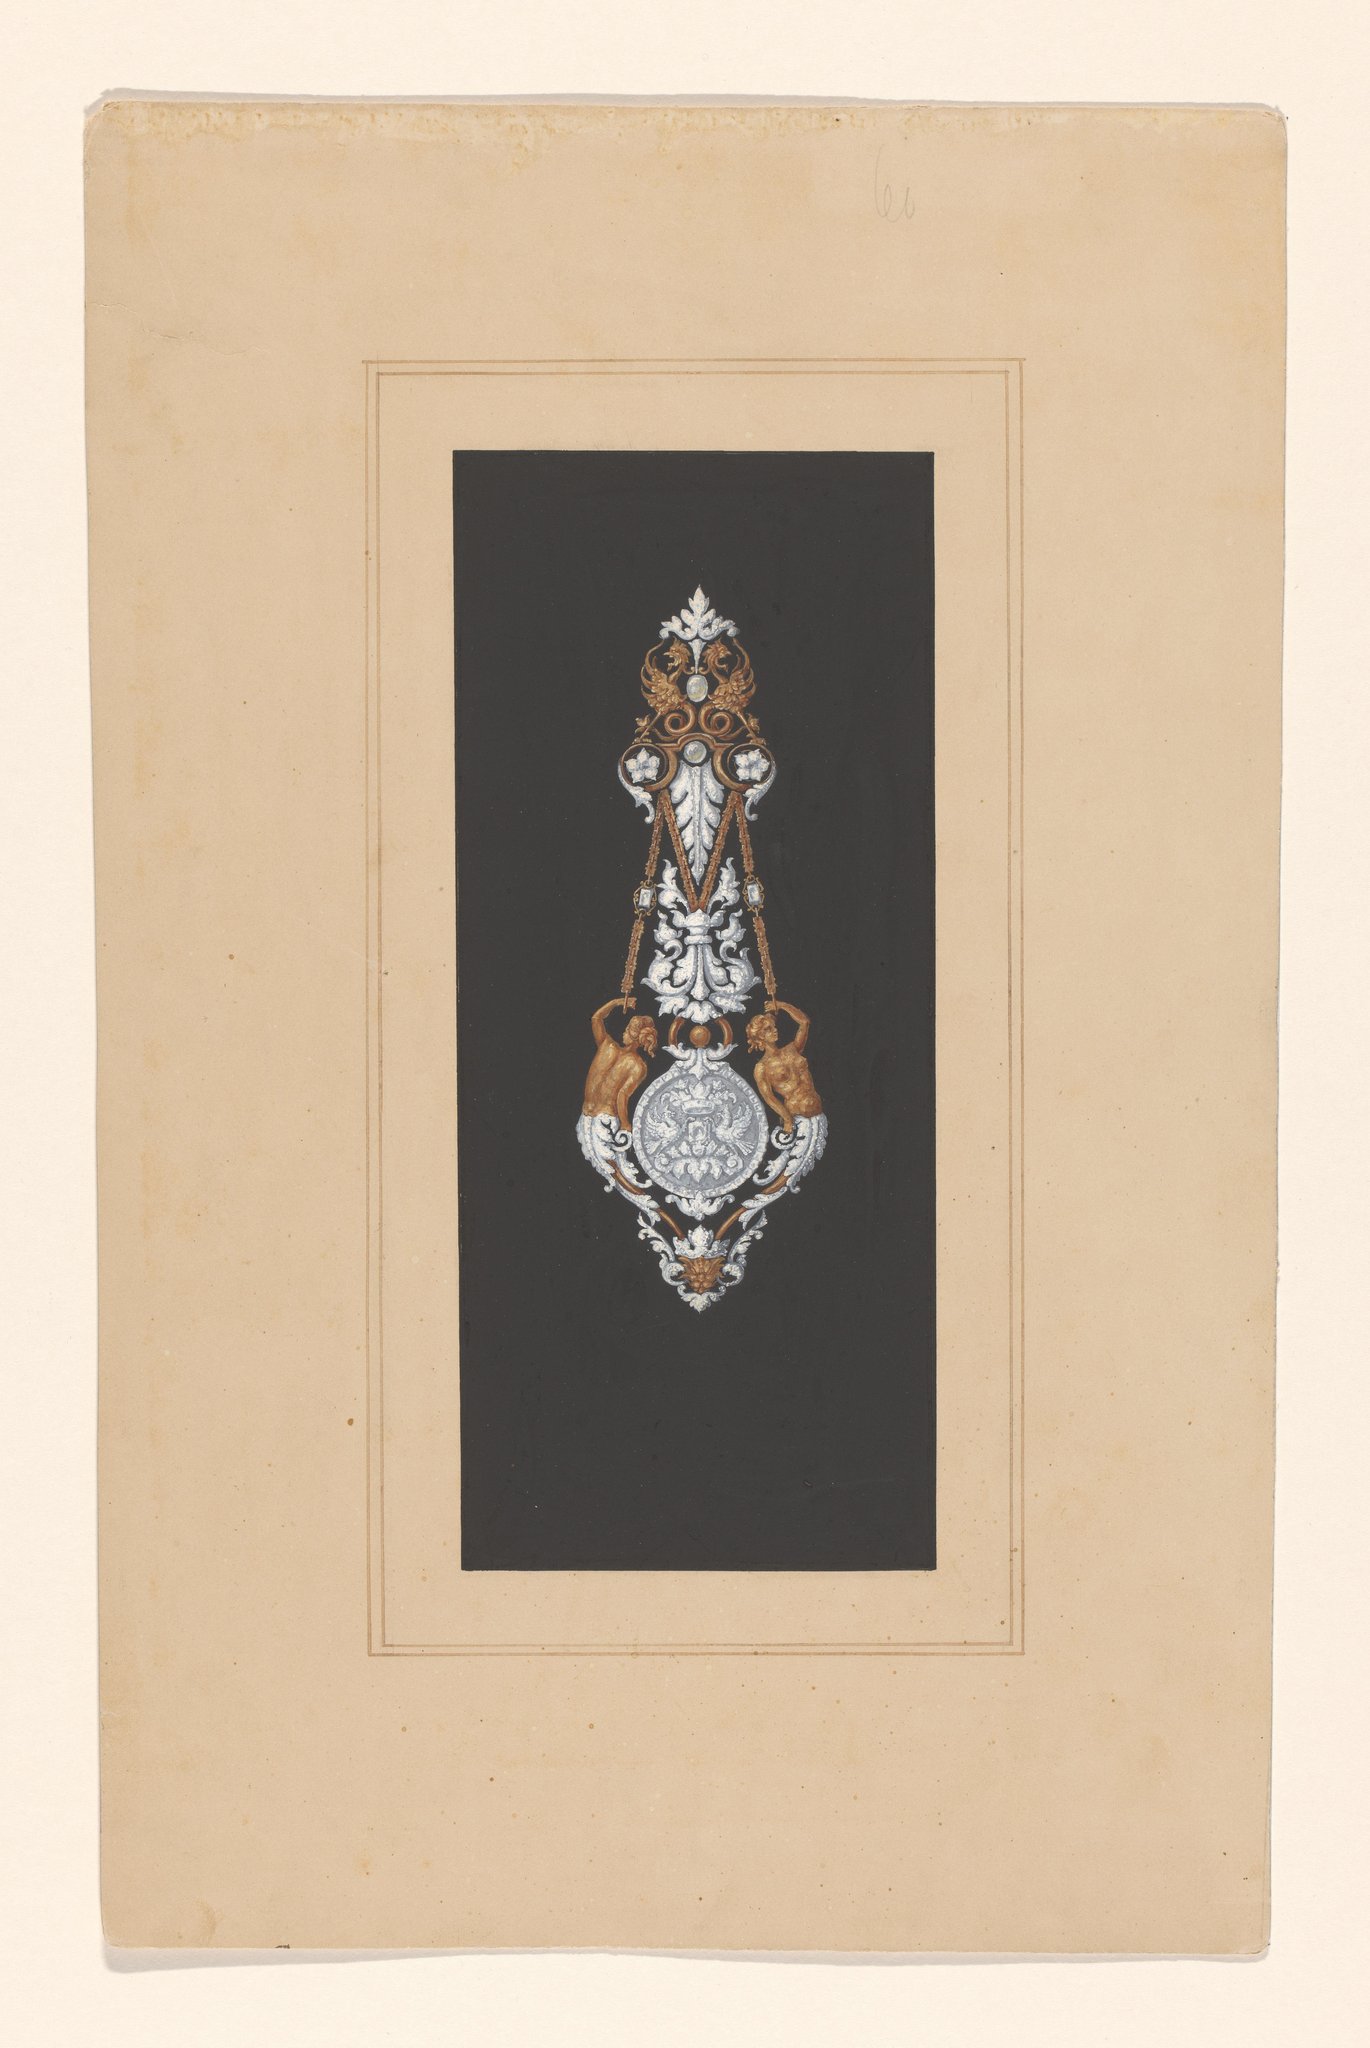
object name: design drawing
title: Een chatelaine met horloge van goud met diamanten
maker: Anonymous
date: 1870-1880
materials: cardboard, gouache, graphite, paper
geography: paris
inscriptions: number: ‘60 [?]’, collector's mark: ‘Col. / L. BONGARD’